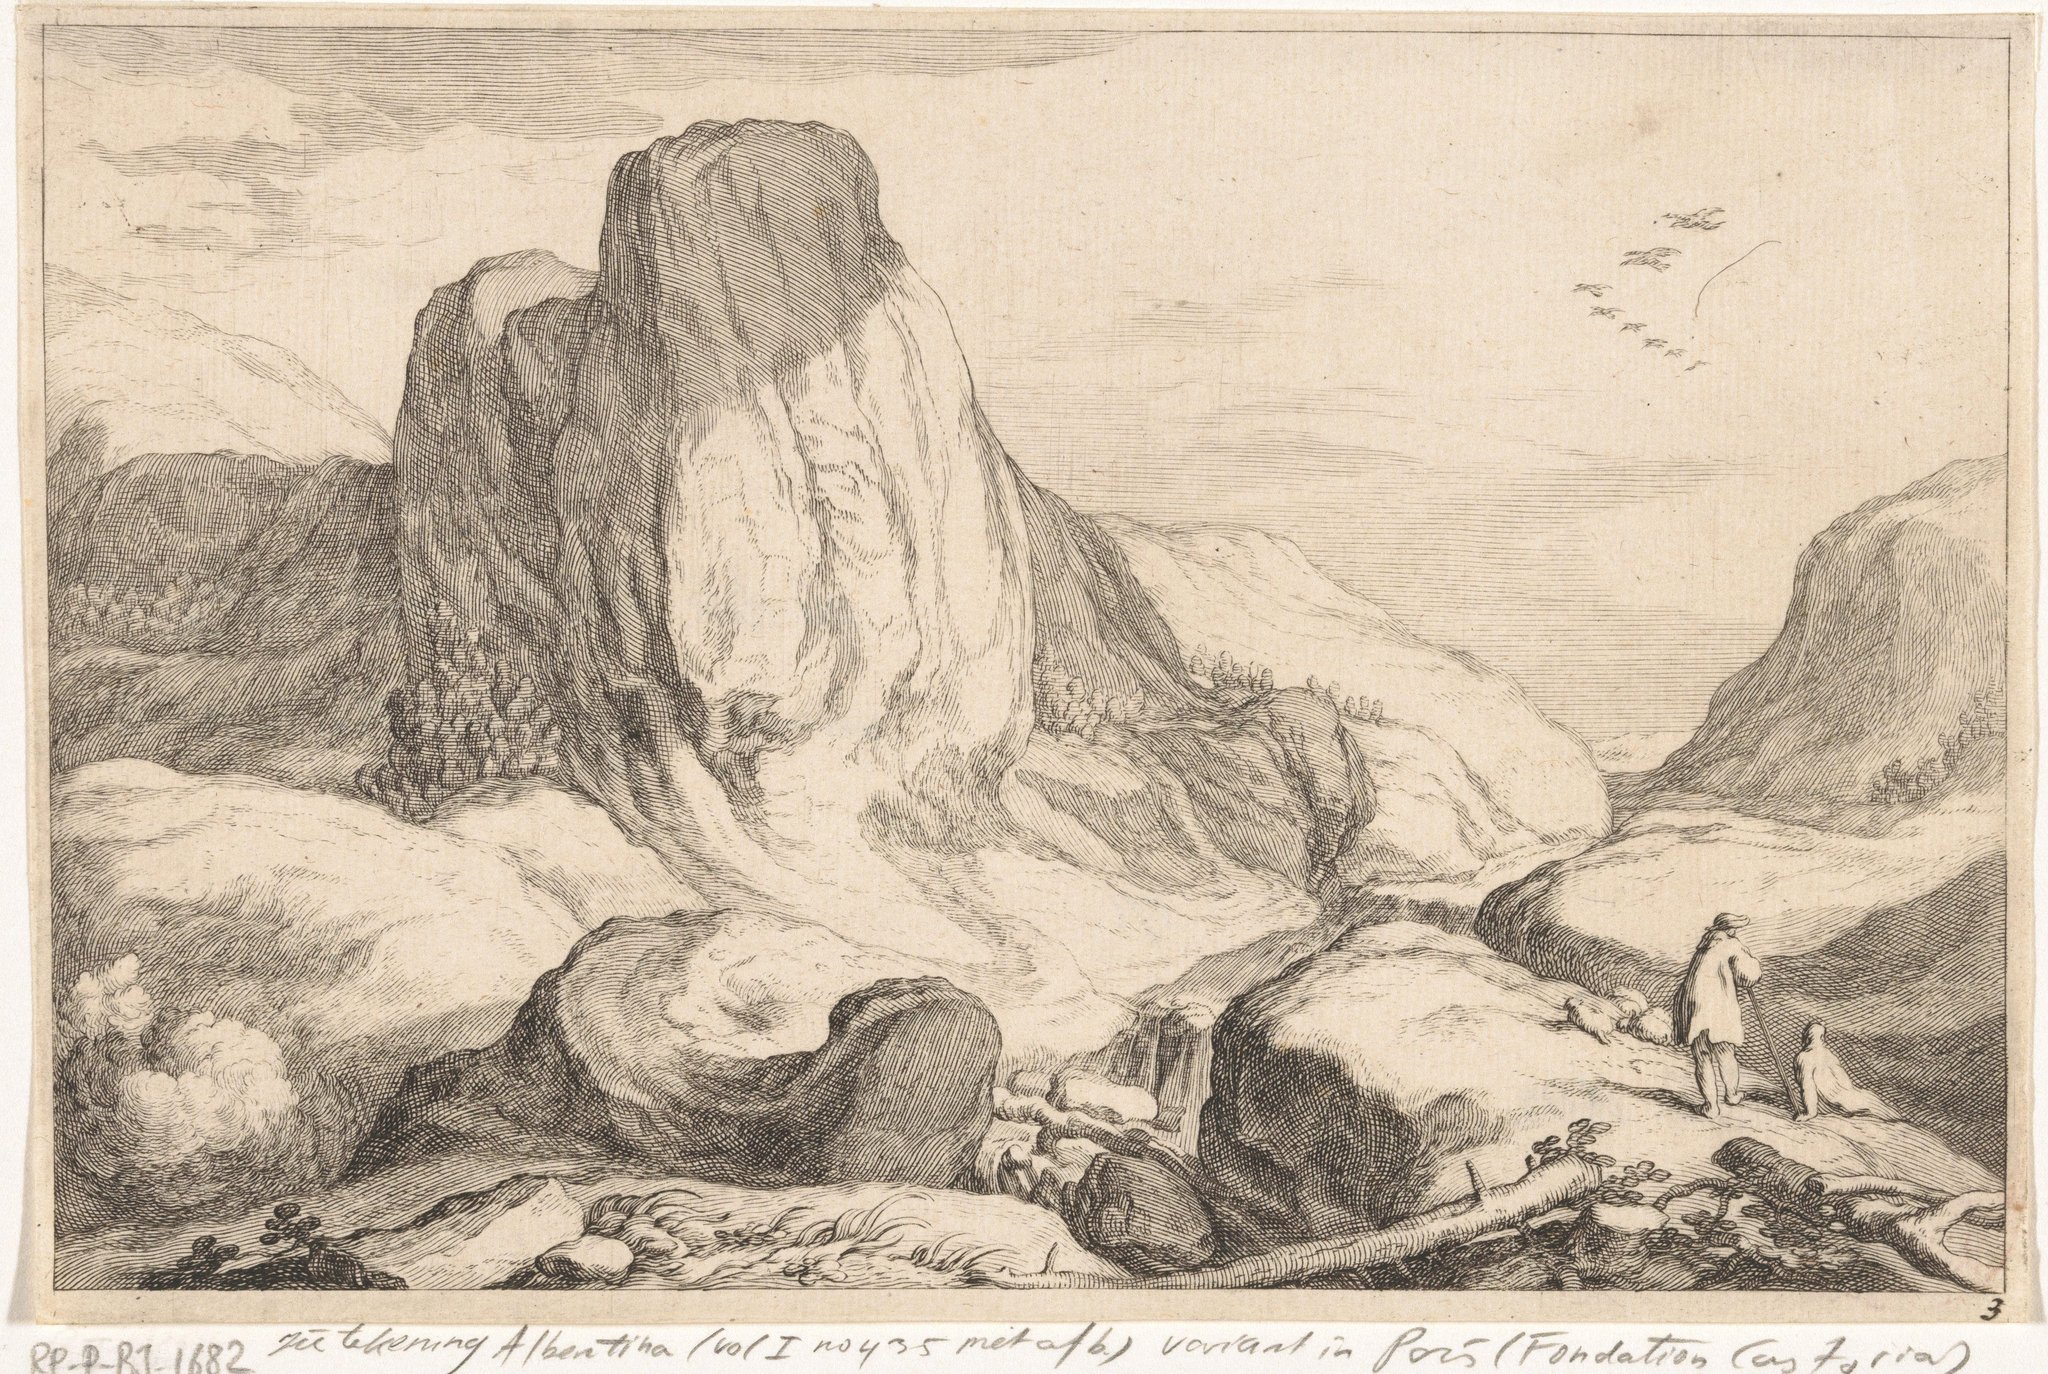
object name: print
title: Rotsachtig landschap met twee herders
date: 1647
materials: paper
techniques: engraving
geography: utrecht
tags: rock-formations, mountains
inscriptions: collector's mark: Lugt 240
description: In een weids berglandschap zijn twee herders en een paar schapen te zien. Deze prent maakt deel uit van een losse groep van elf prenten, waarvan enkel de nummers 1-6 (later?) genummerd zijn.